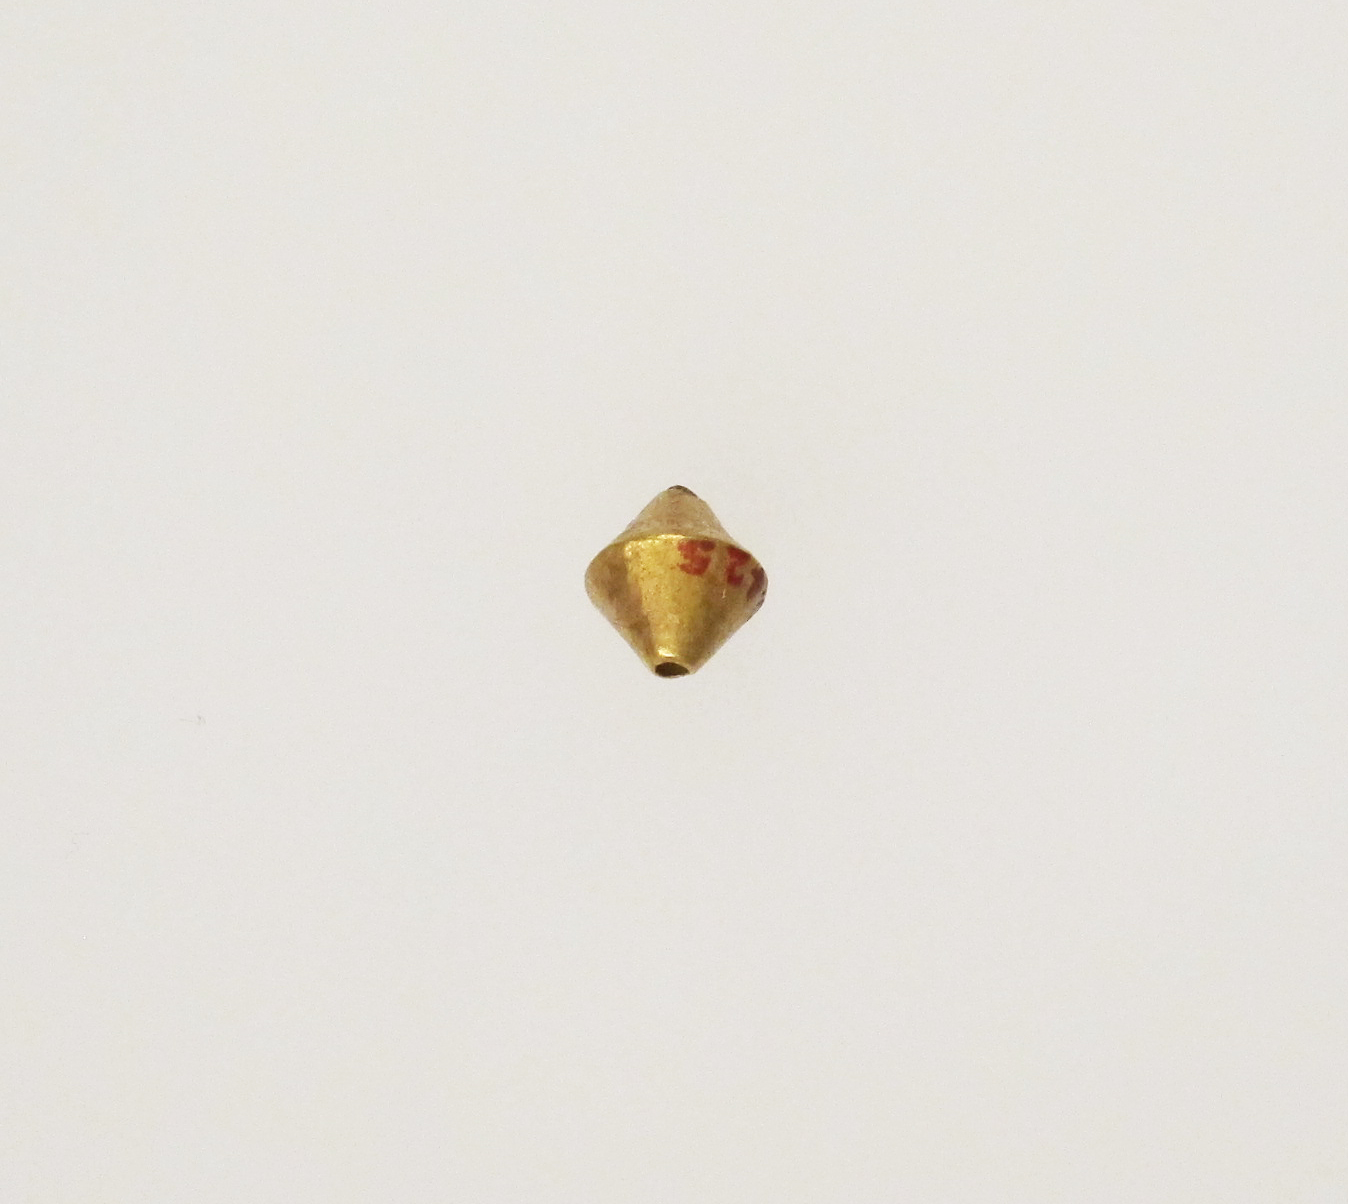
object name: bead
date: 7000 BCE-330 CE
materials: gold